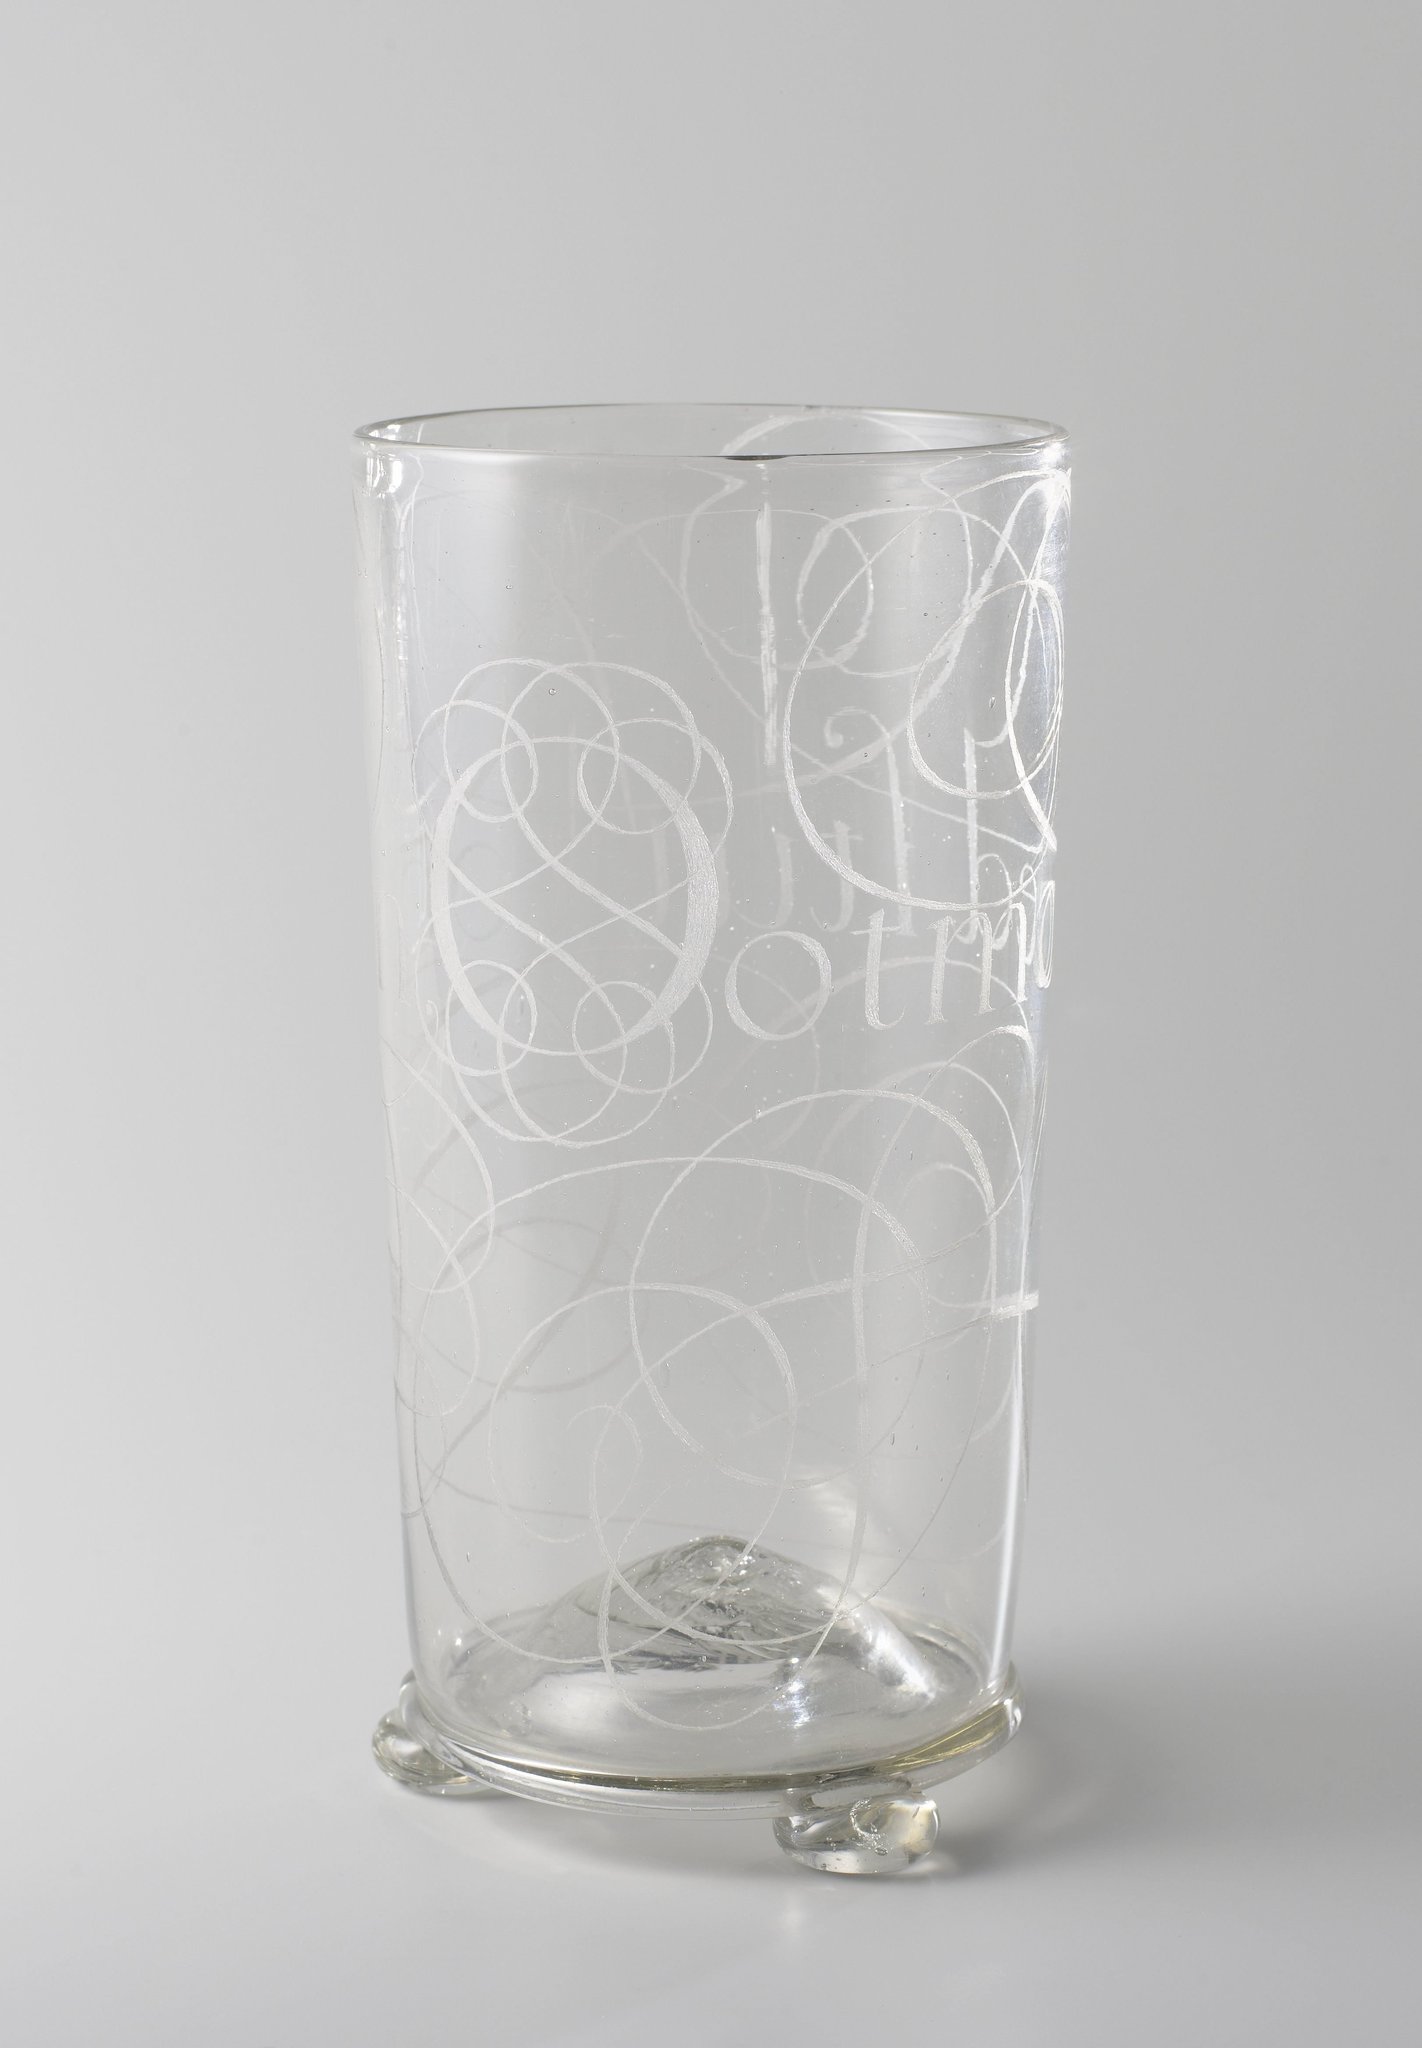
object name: cup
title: Beker op pootjes met het opschrift: Ootmoed Stut toorn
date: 1679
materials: glass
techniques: diamond point engraving, façon de venise, glassblowing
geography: leiden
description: Cylindervormige beker met ingestoken ziel, staande op drie bolle pootjes. De onderrand afgewerkt met een gladde, aangezette draad. Op het lichaam is in romeinse ronde letters gecalligrafeerd 'Ootmoed Stut toorn.' en op de bodem rond het pontilmerk 'Willem van Heemskerk Anno 1679'.